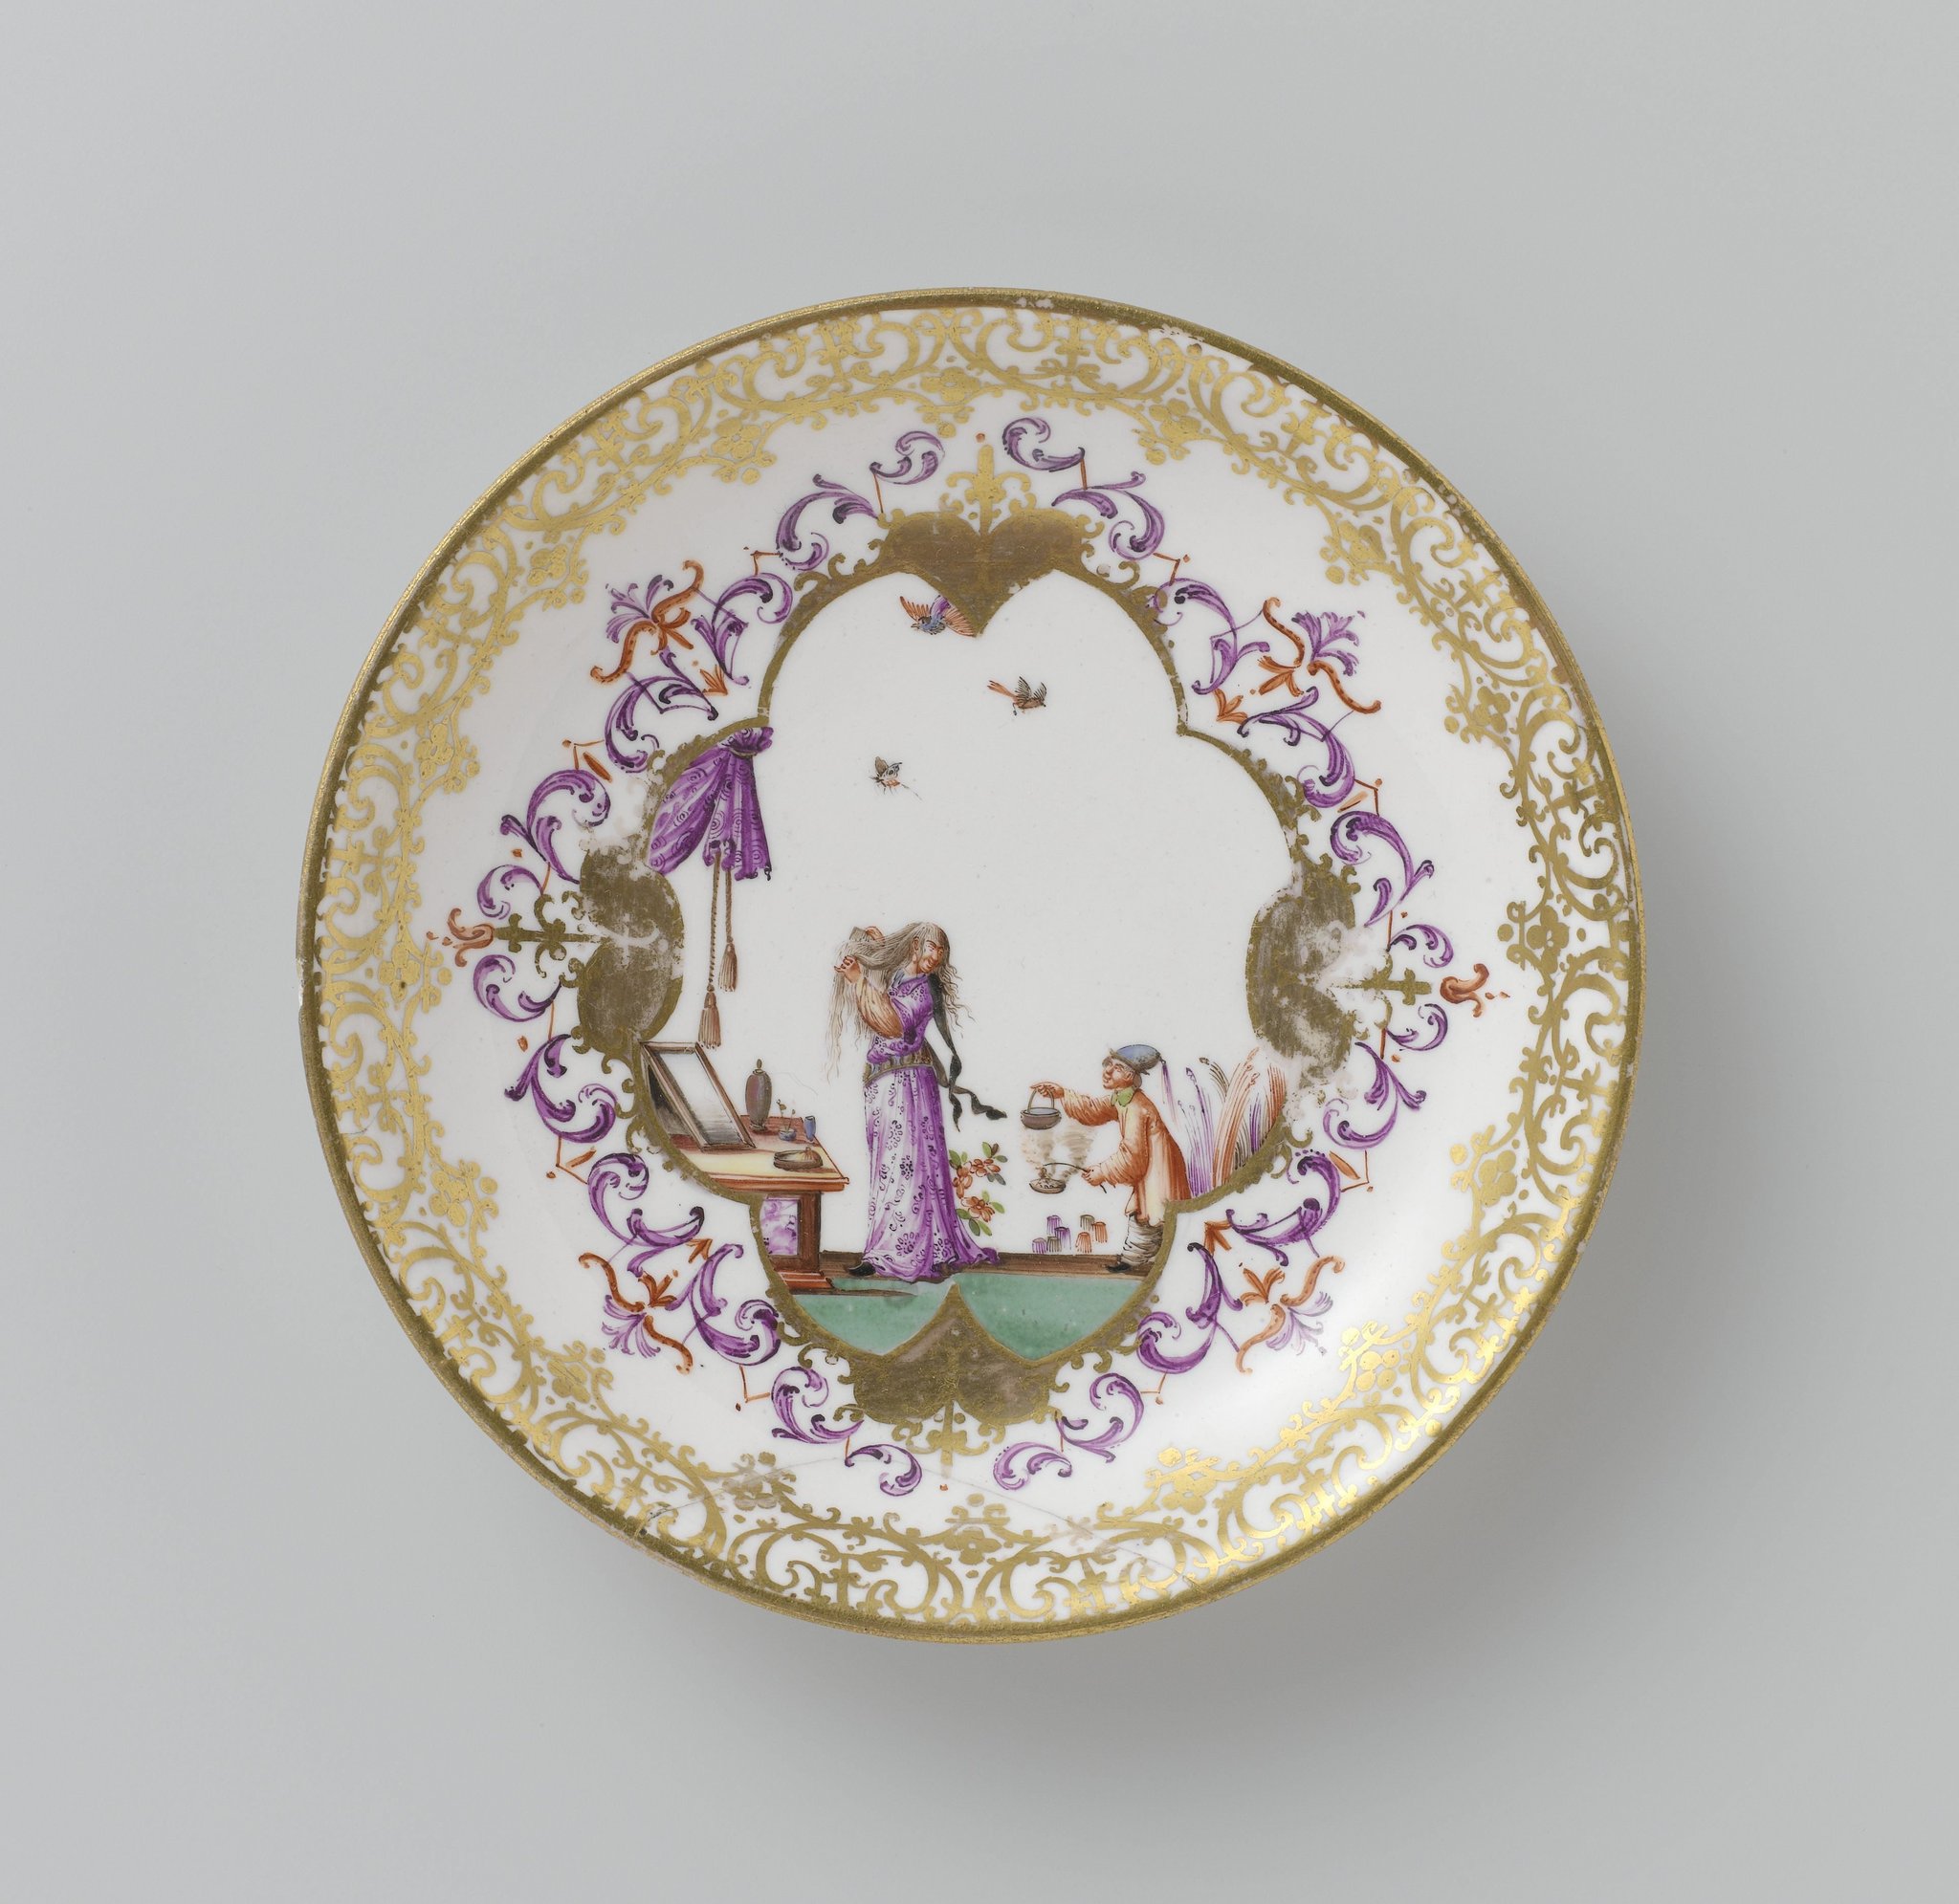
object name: platter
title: Chocolate cup and saucer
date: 1725-1730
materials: porcelain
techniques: painted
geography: meissen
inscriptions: label: ‘SAMMLUNG / Dr. FRANZ OPPENHEIMER’, number: ‘178.’, mark, factory mark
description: Meissener Porzellan Manufaktur Meissen, c. 1725–1730 hard-paste porcelain